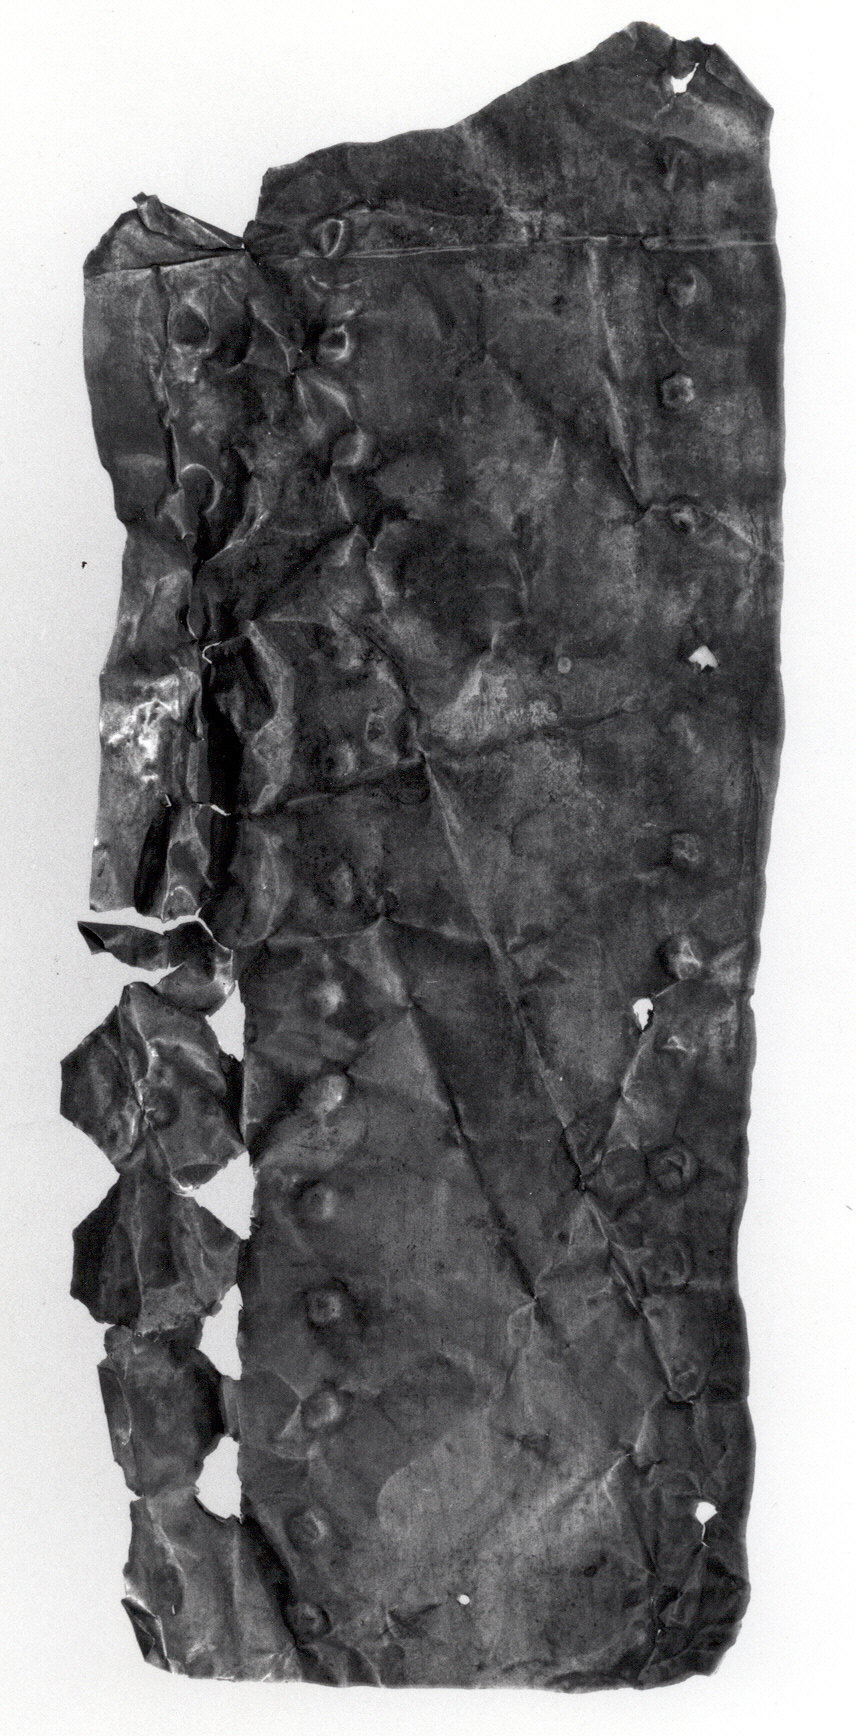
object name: sheathing fragment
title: Hammered Gold Sheathing Fragment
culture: peruvian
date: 1001-1600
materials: gold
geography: peru